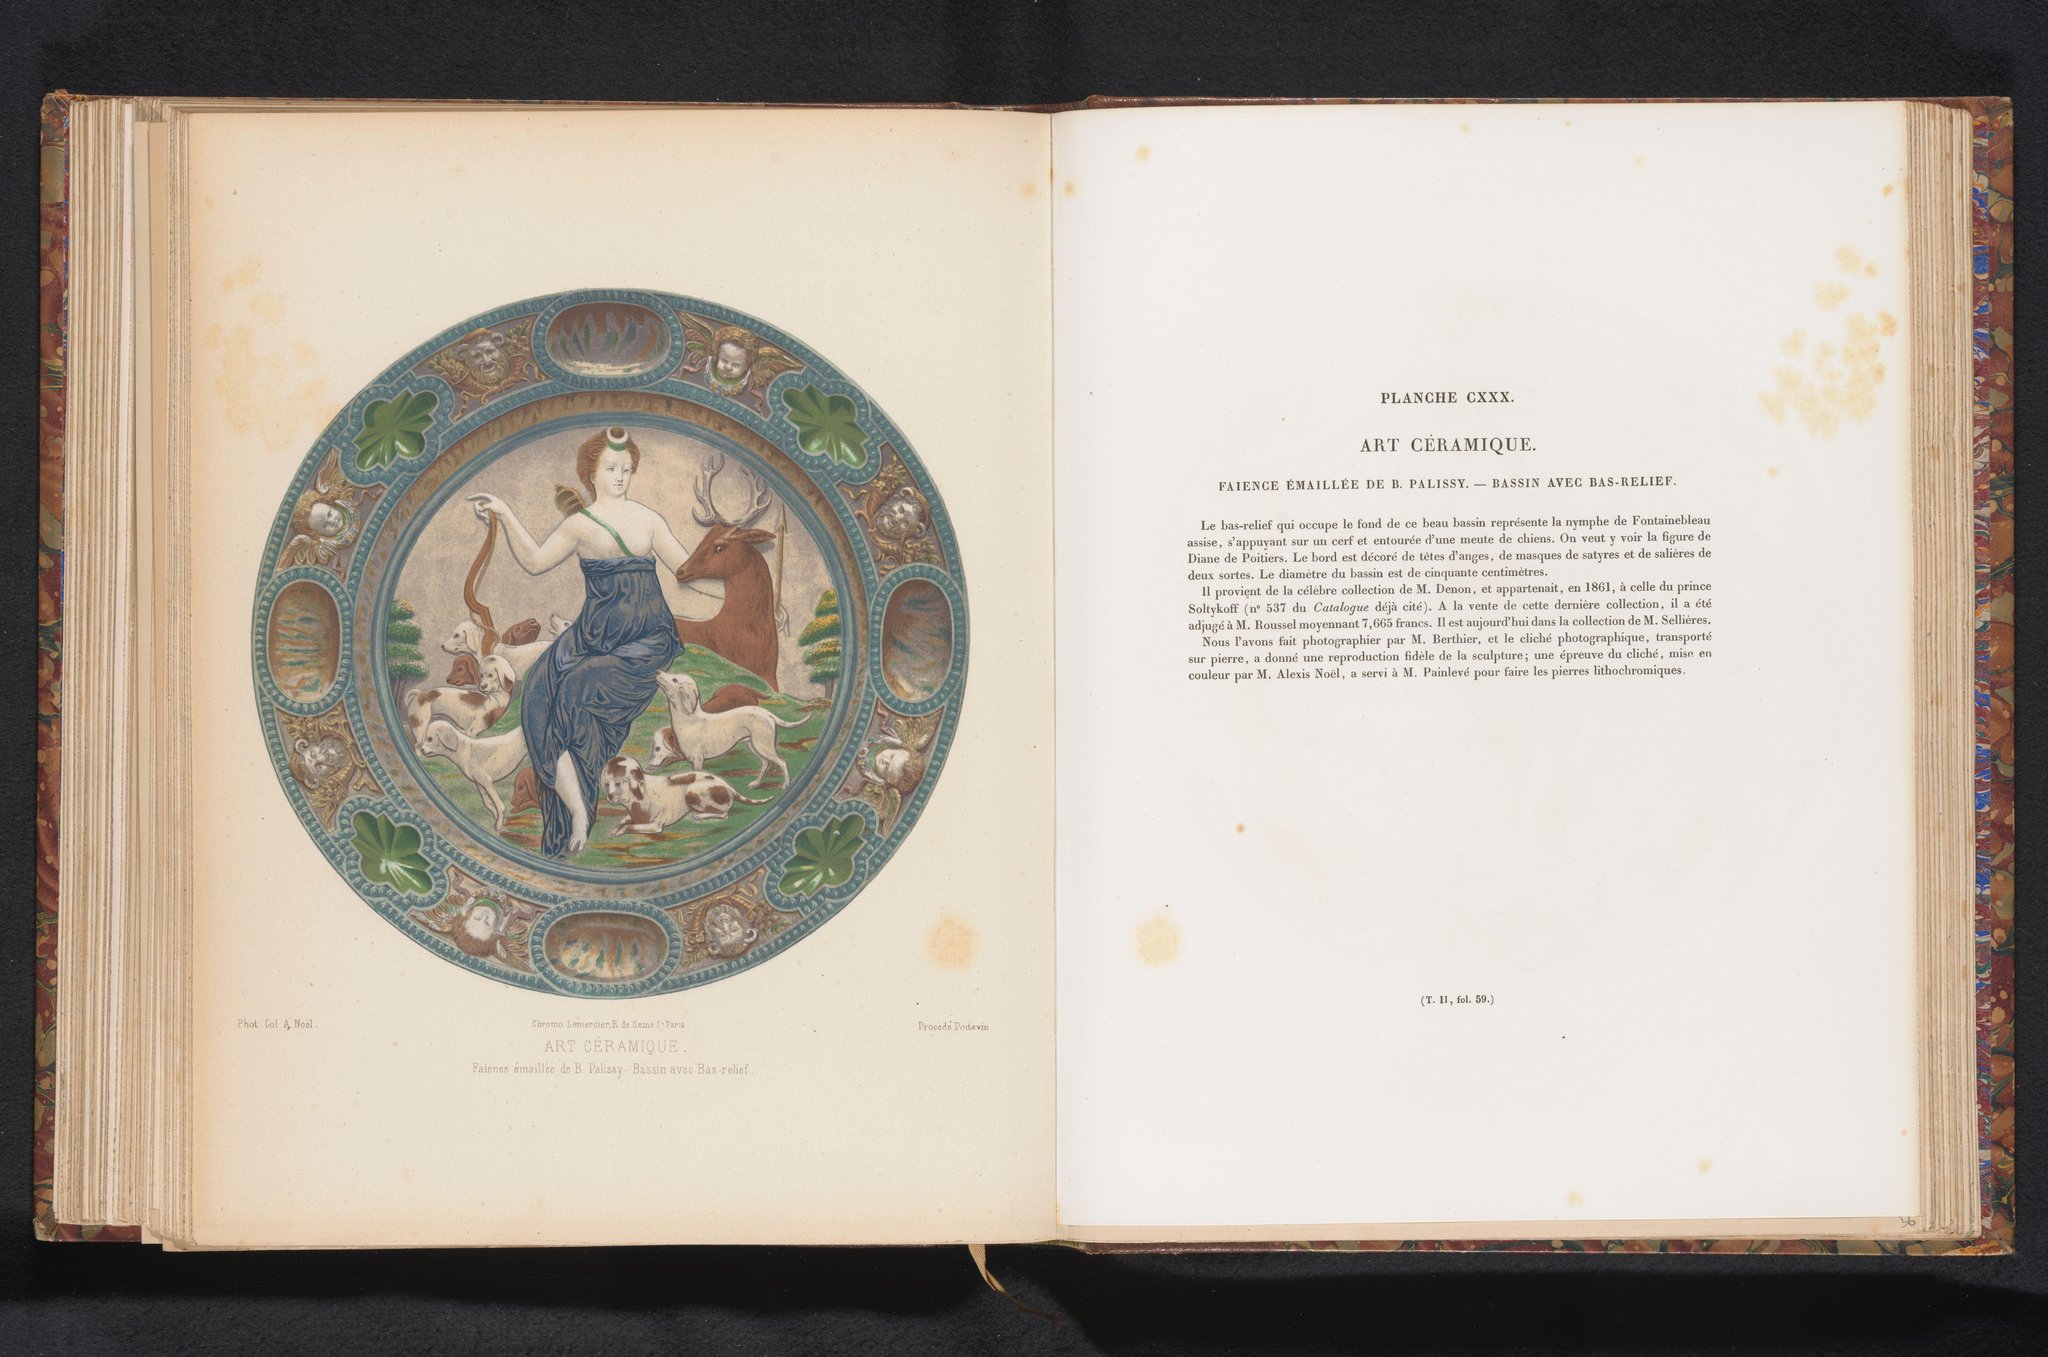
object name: reproduction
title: Reproductie van een ontwerp van een schaal met een zittende nimf omrind door een hert en een roedel honden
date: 1859-1864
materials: paper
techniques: photolithography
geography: paris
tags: hoofed animals: deer, nymphs (in general); 'ninfe in commune' (ripa), dog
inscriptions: name: ‘Phot. col. A. Noël./ Procede Poitevin’